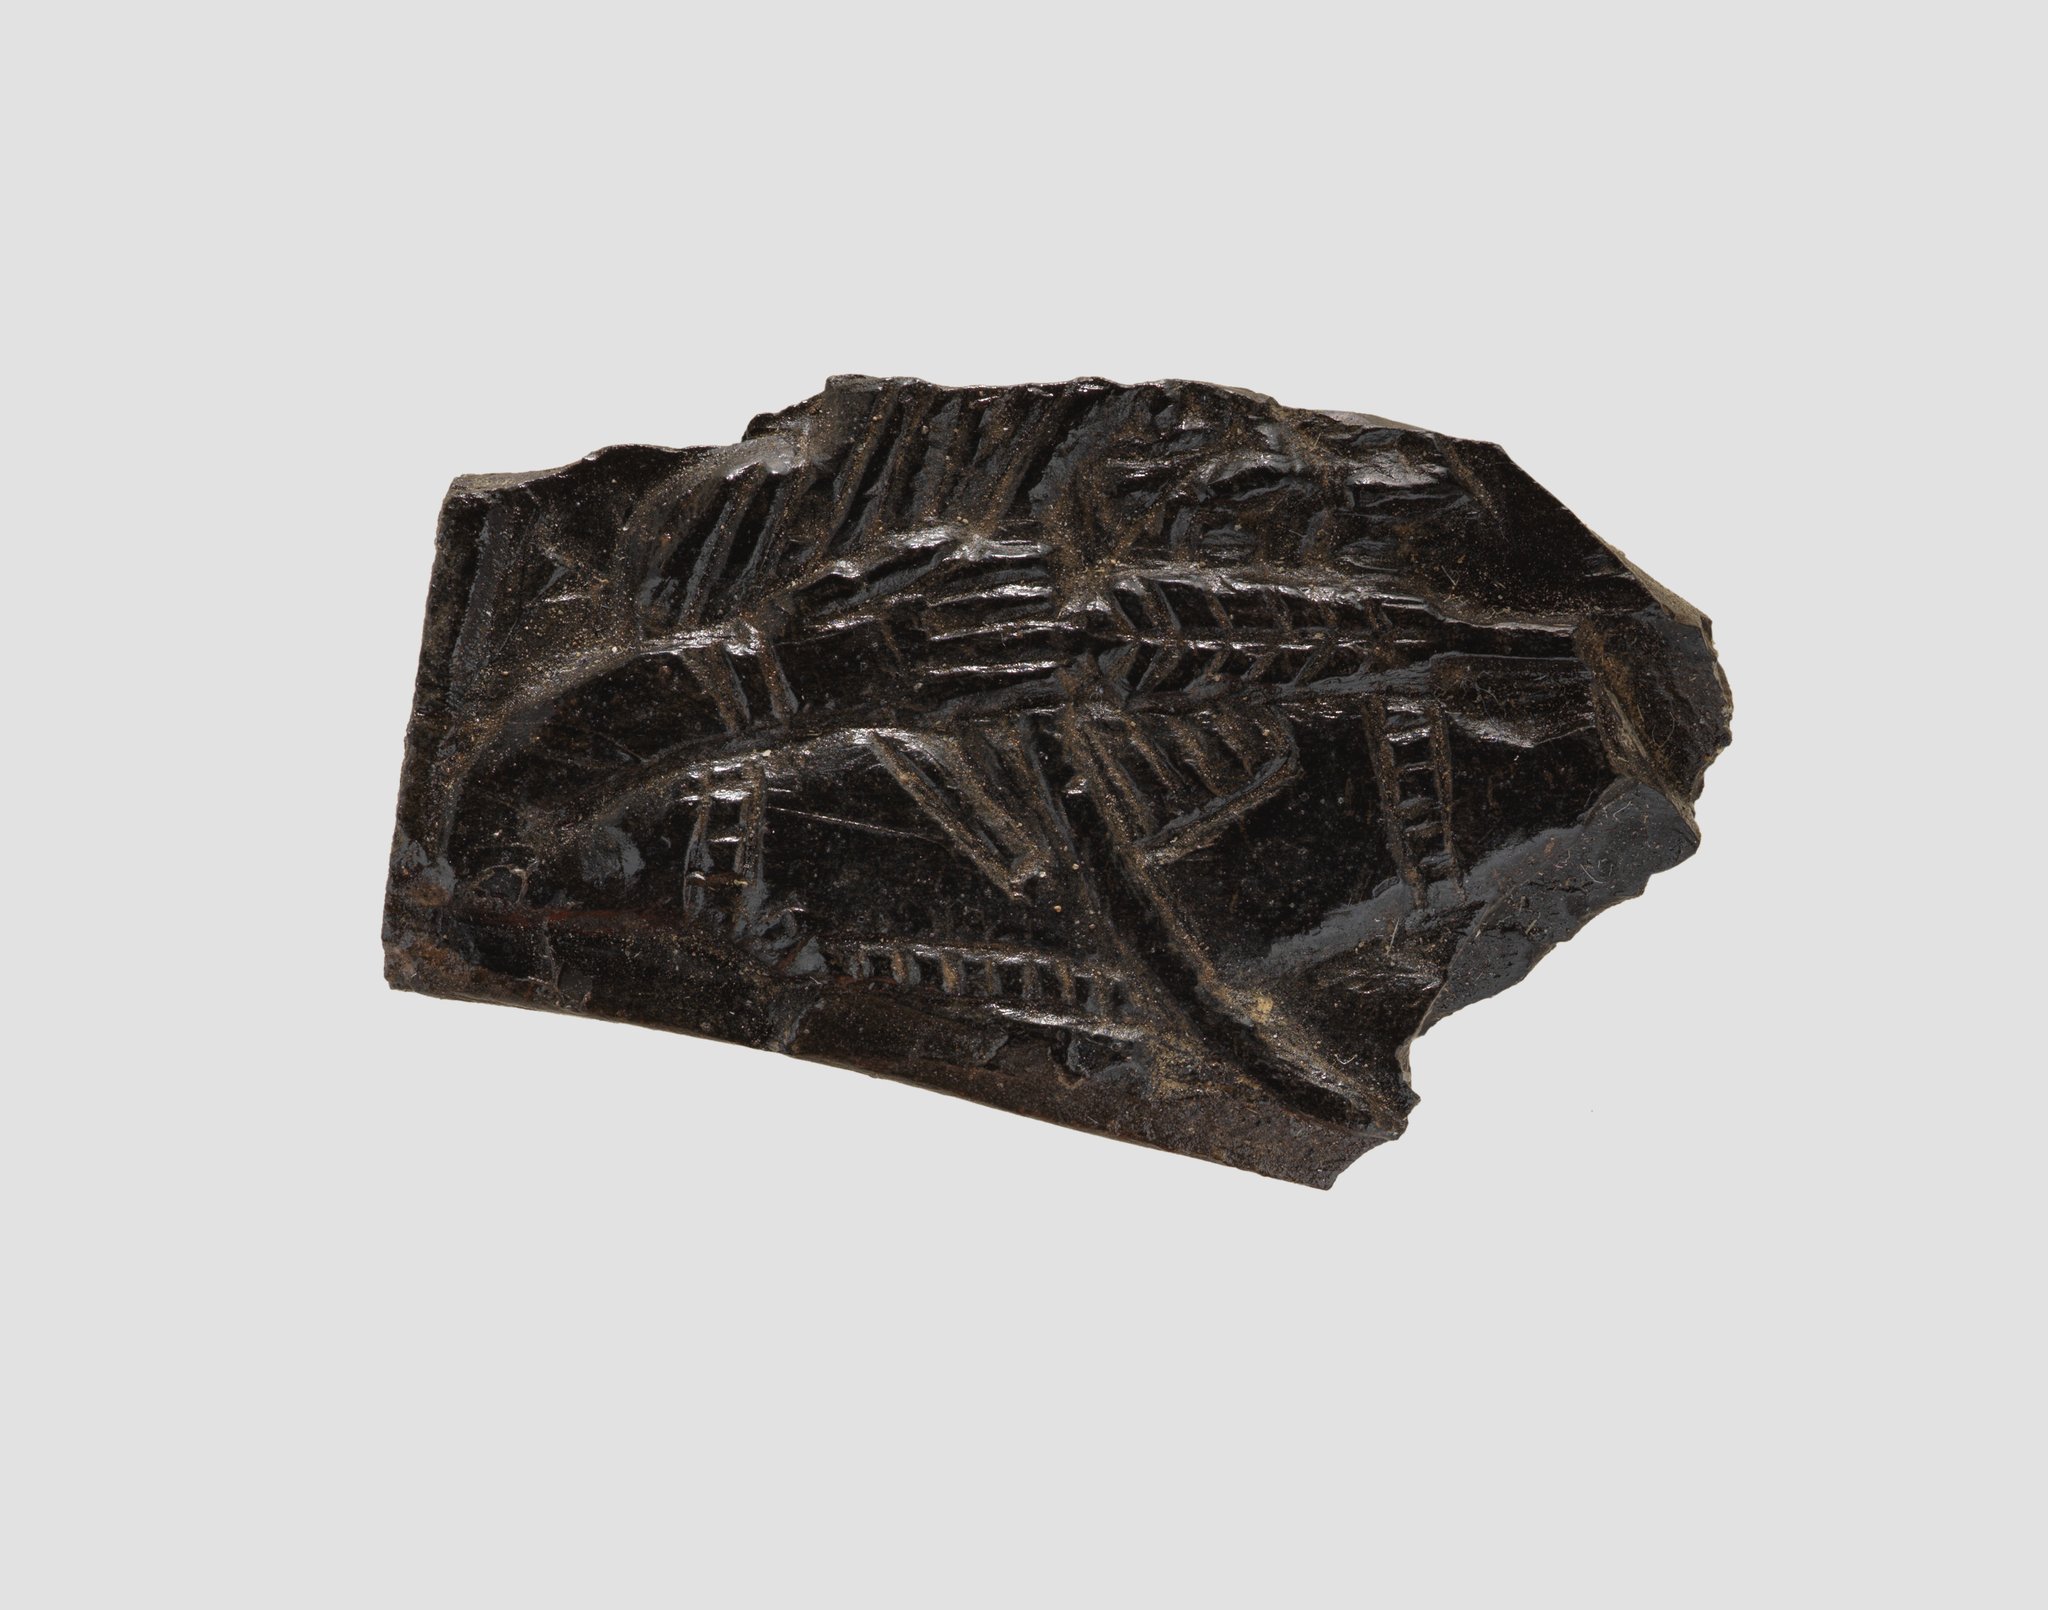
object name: relief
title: Plaque fragment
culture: iranian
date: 900-801 BCE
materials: ivory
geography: iran